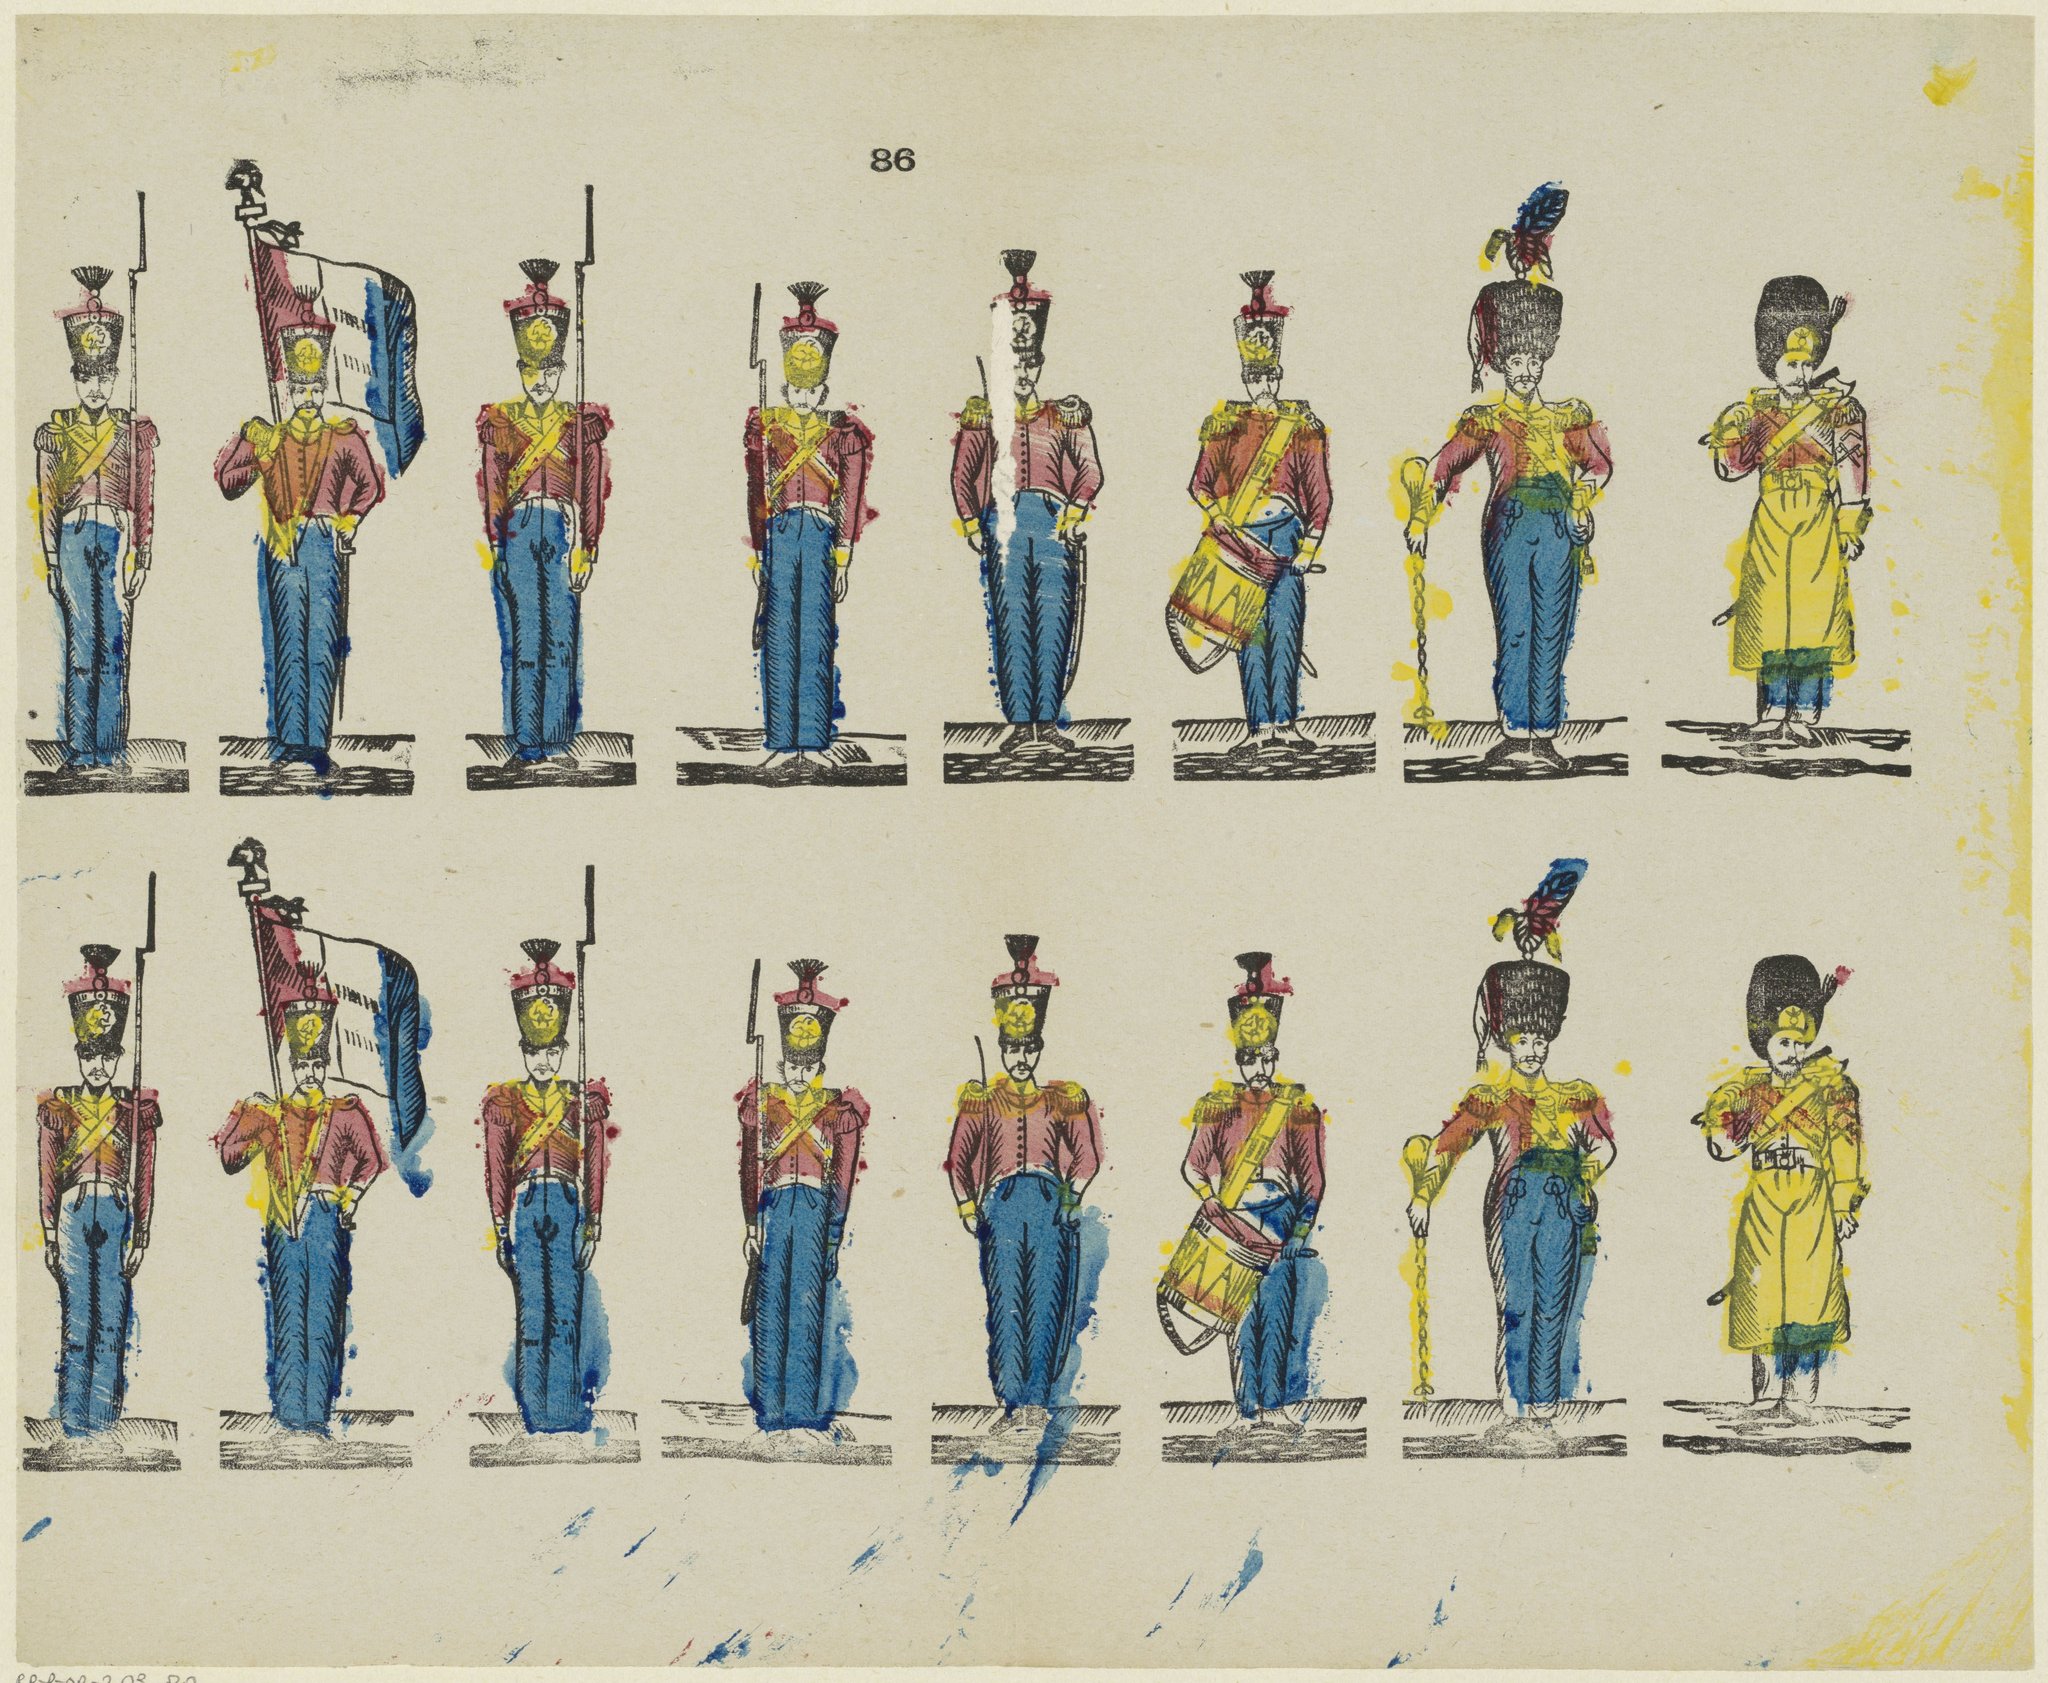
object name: print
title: Militairen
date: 1827-1894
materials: paper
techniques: colour, letterpress printing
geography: schaarbeek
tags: the soldier; the soldier's life, (military) uniforms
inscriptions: collector's mark: Lugt 2760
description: Blad met 16 voorstellingen van verschillende militairen. Genummerd midden boven: 86.